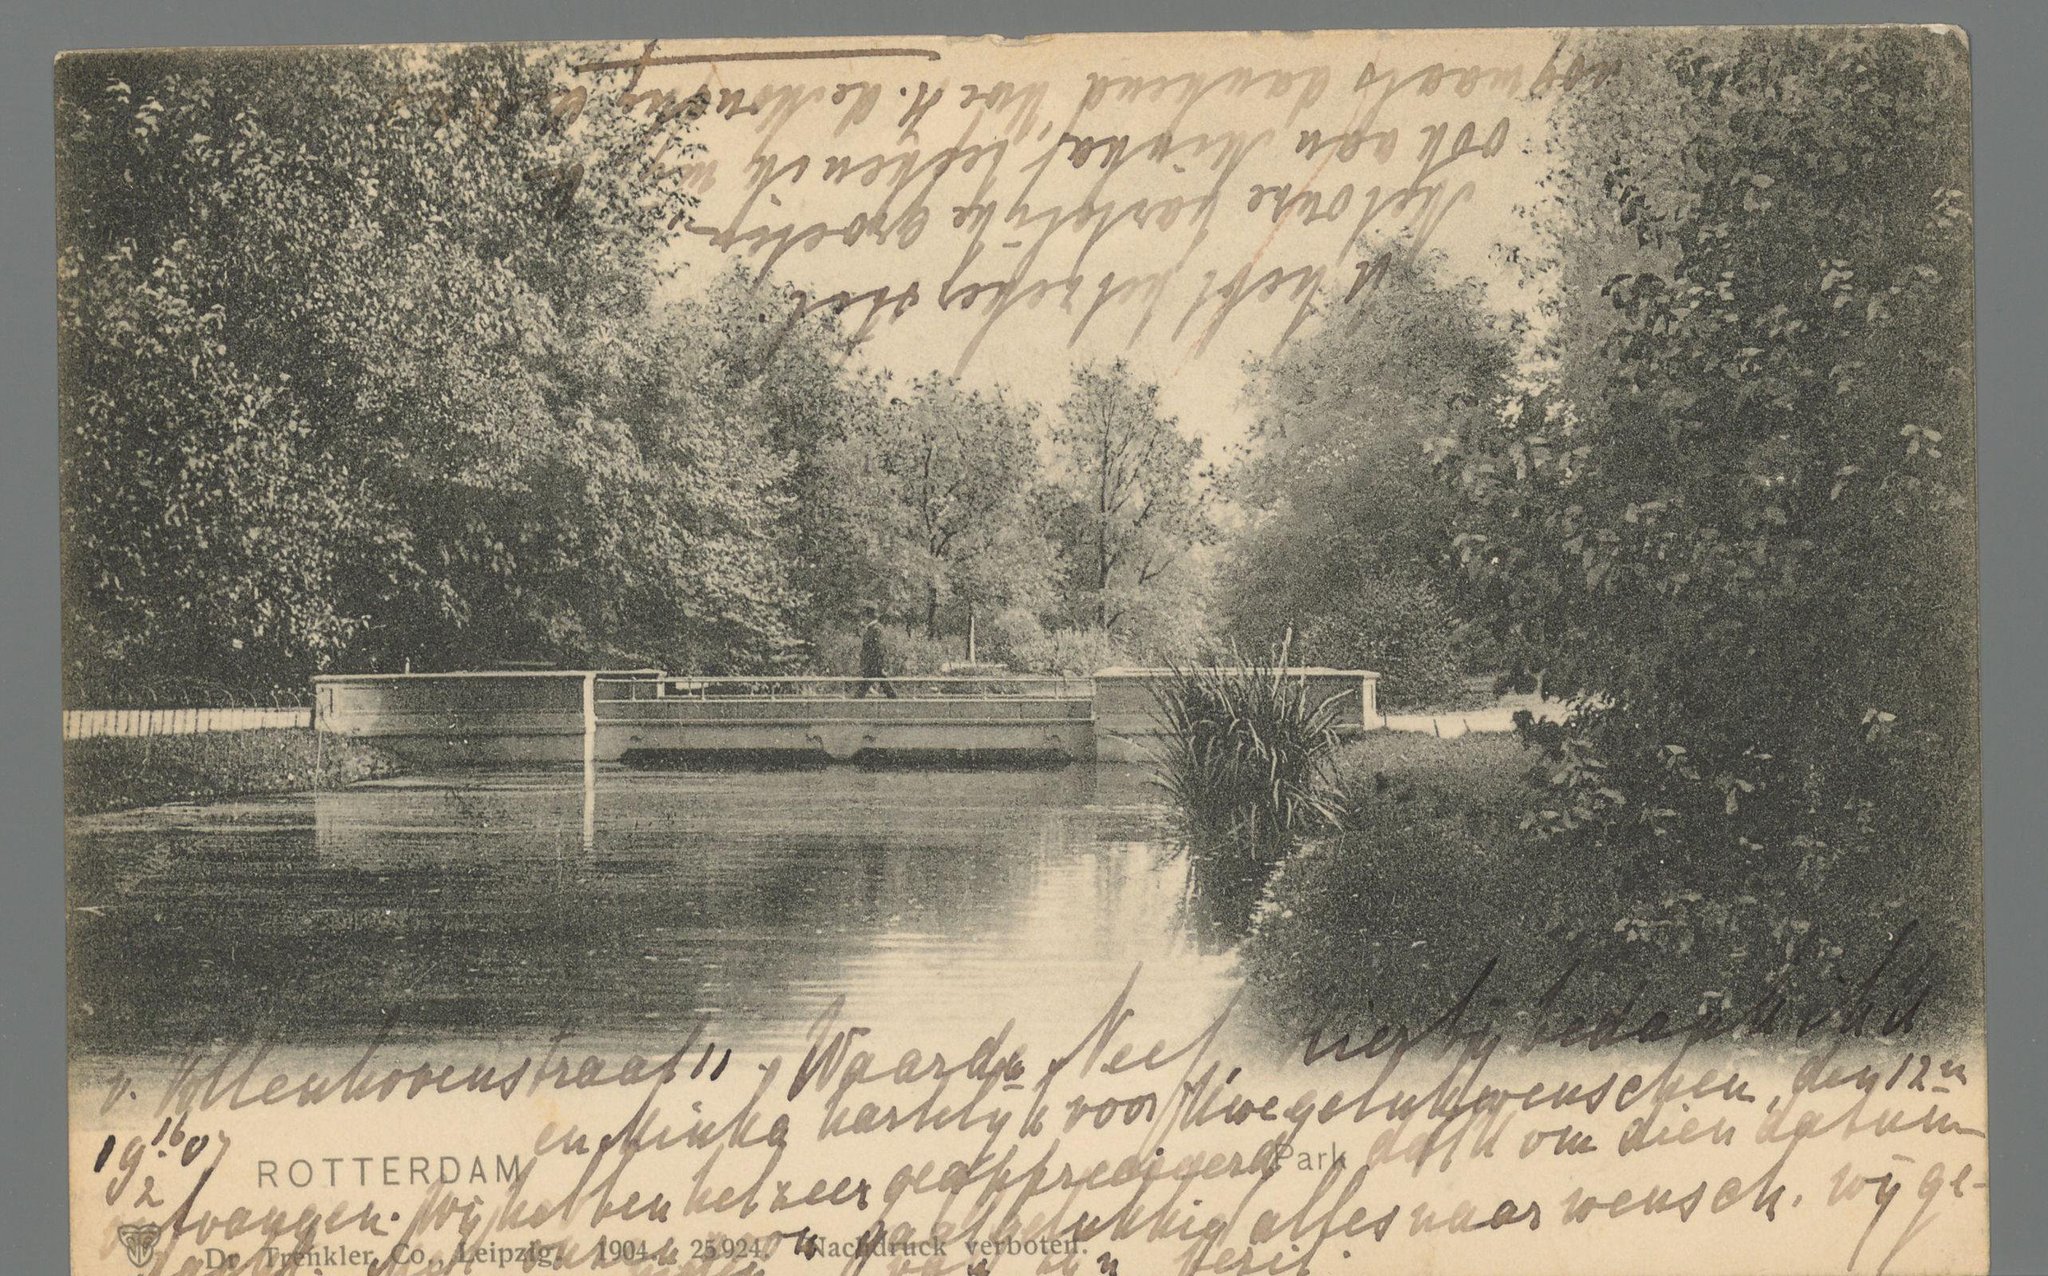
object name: photomechanical print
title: Rotterdam. Park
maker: Anonymous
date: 1897-1905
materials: cardboard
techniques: photograph, writing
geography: rotterdam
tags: park, lake, bridge, rotterdam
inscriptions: postage stamp